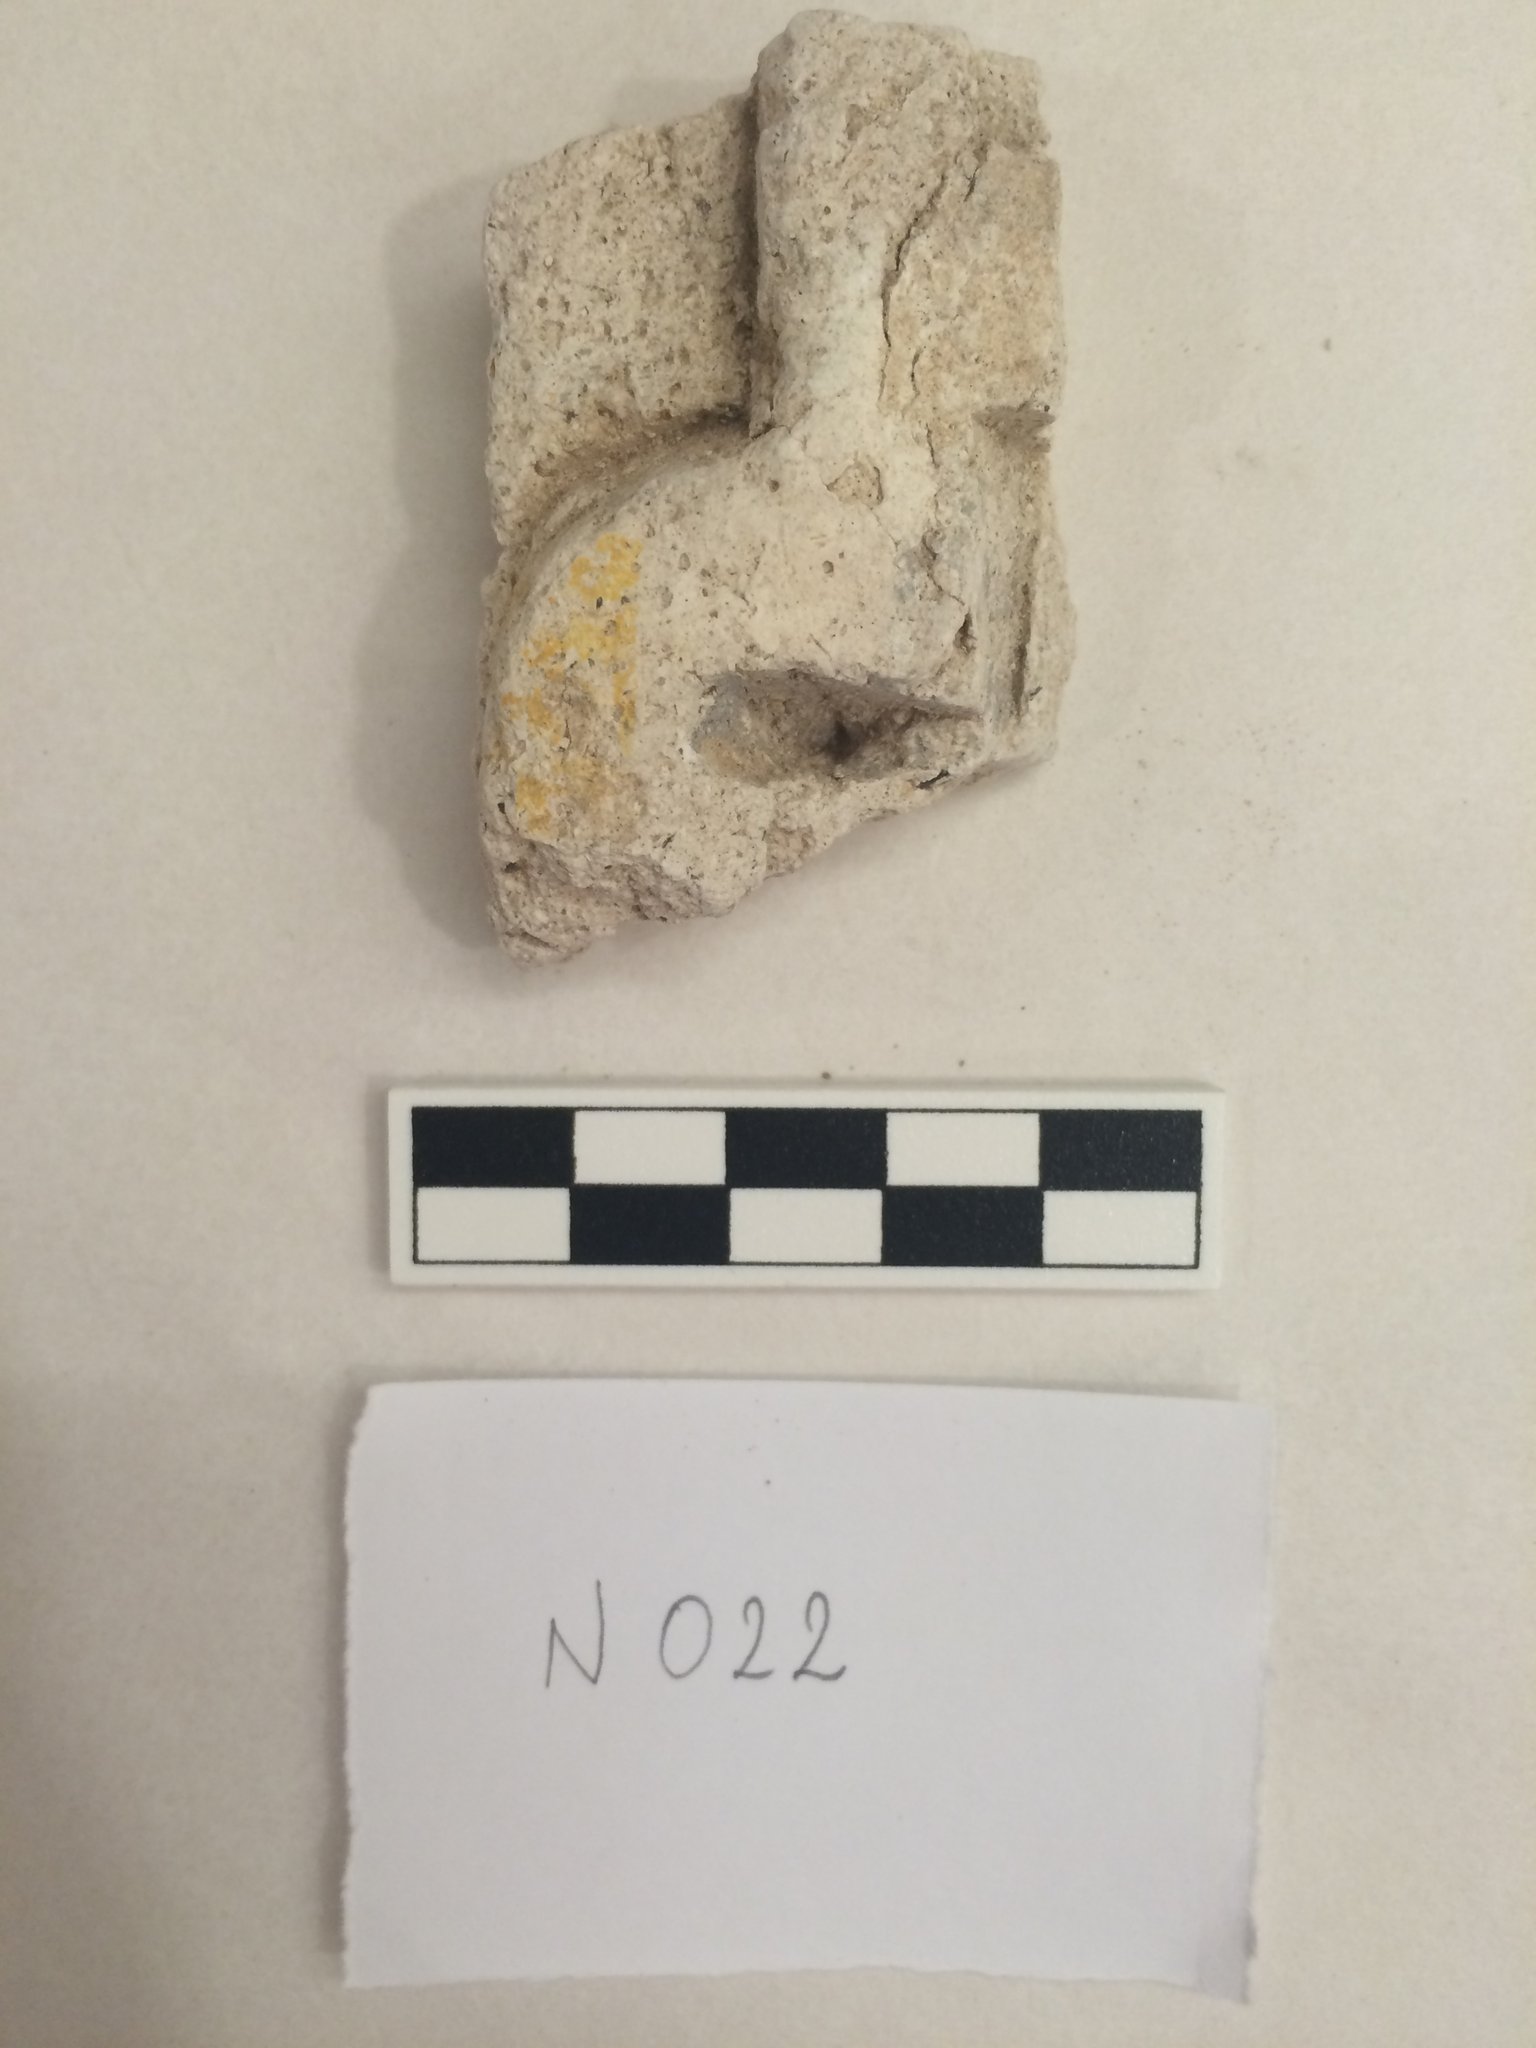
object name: fragment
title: Stucco Fragment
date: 701-1200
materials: plaster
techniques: carving, painting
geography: iran